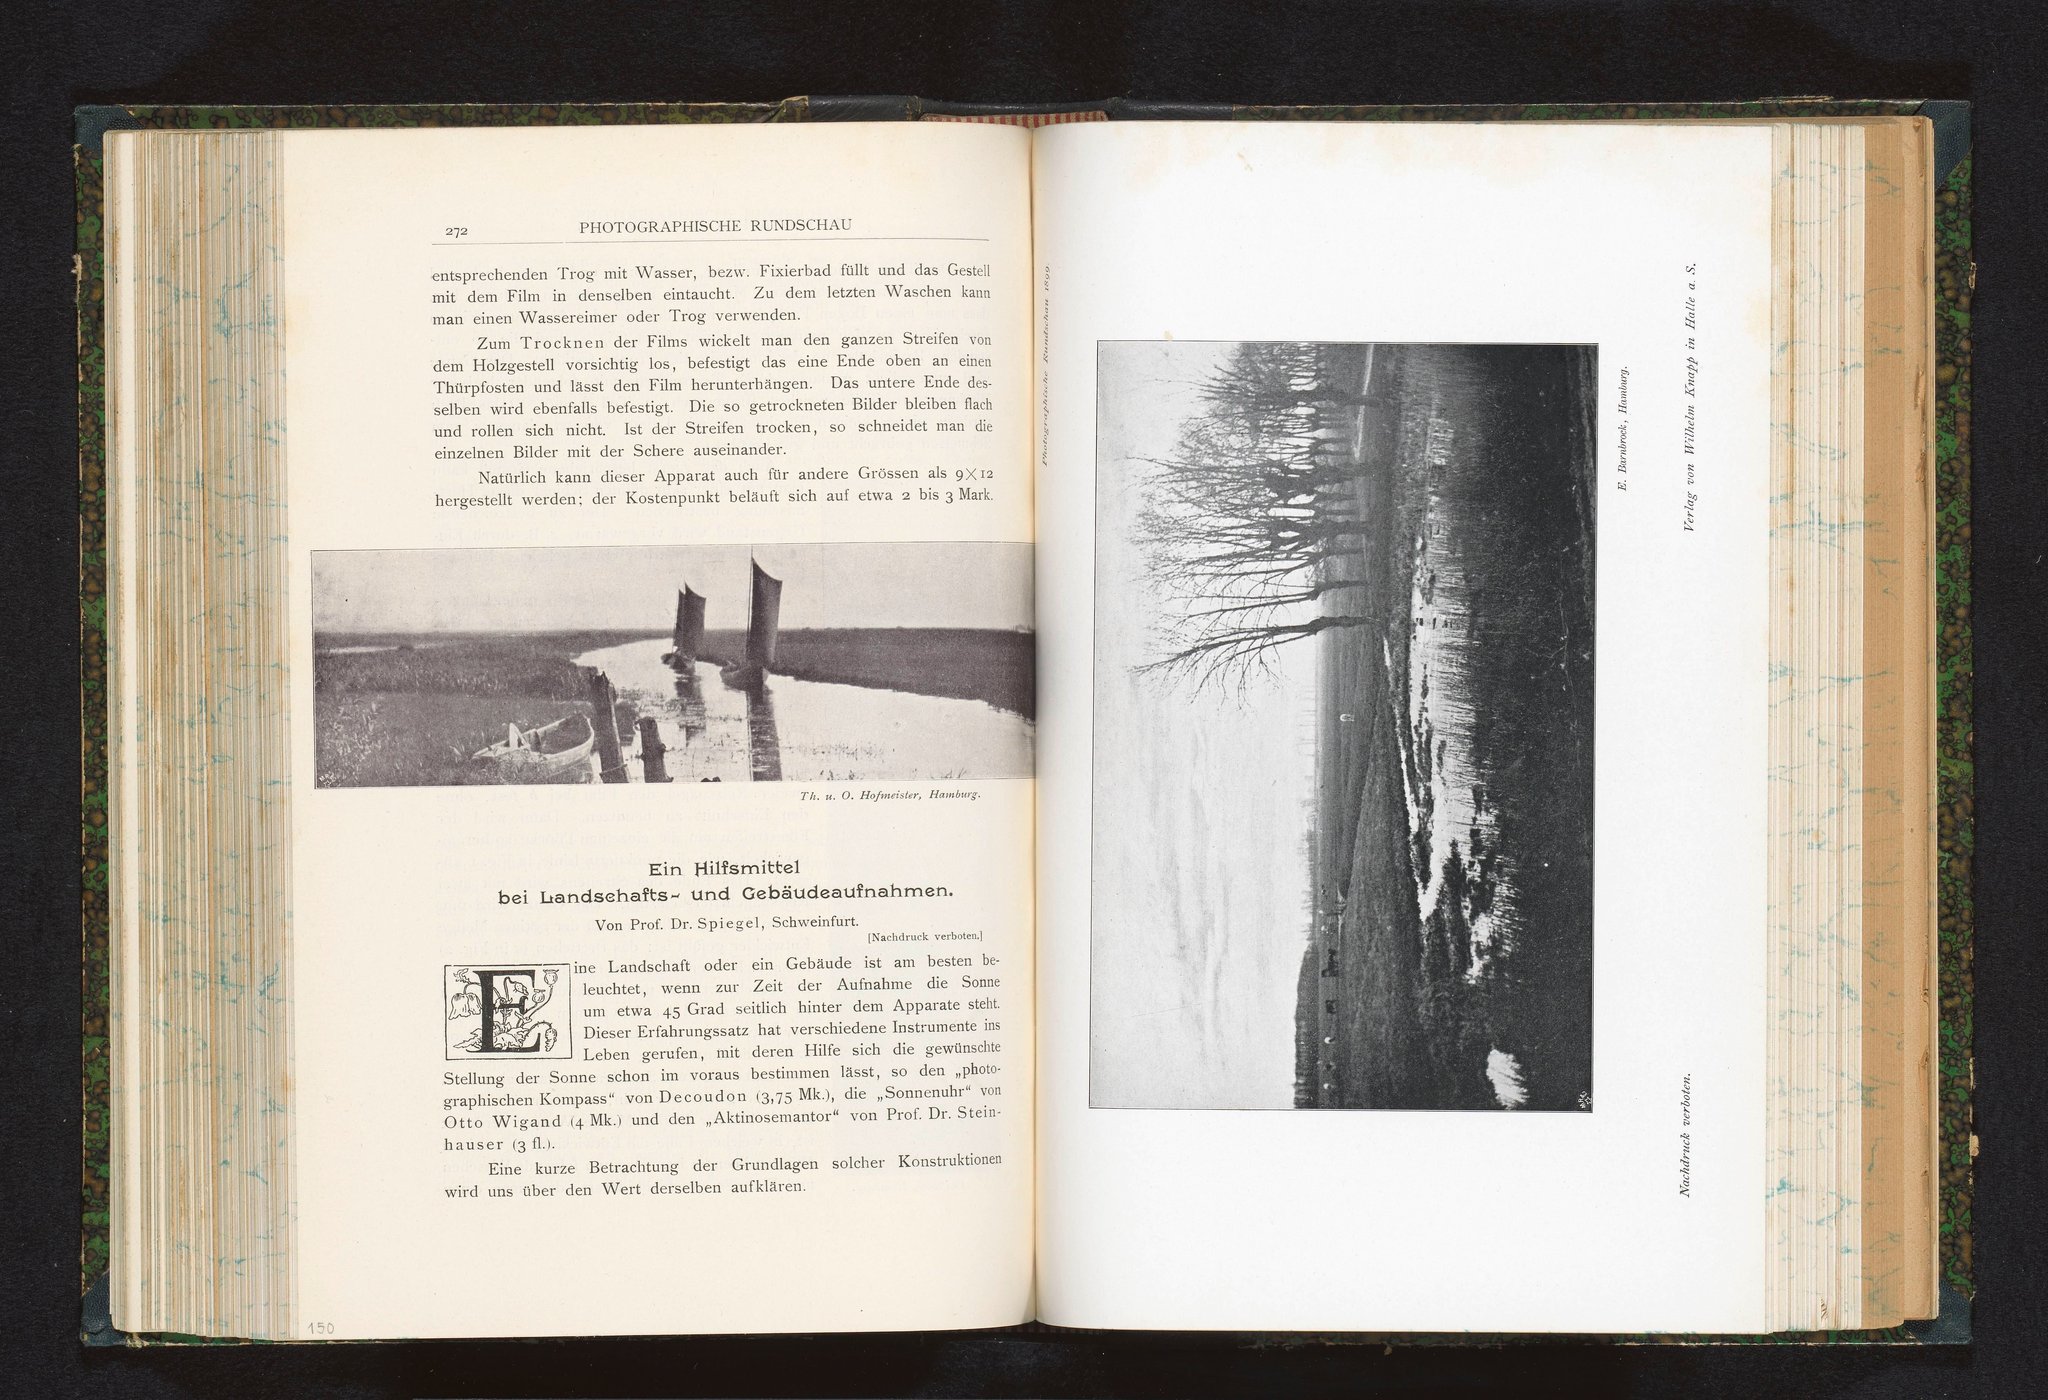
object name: photomechanical print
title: Twee zeilboten op een vaart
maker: th. u. o. hofmeister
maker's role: fotograaf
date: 1894-1899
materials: paper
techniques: autotype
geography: berlin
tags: sailing-ship, sailing-boat, canal